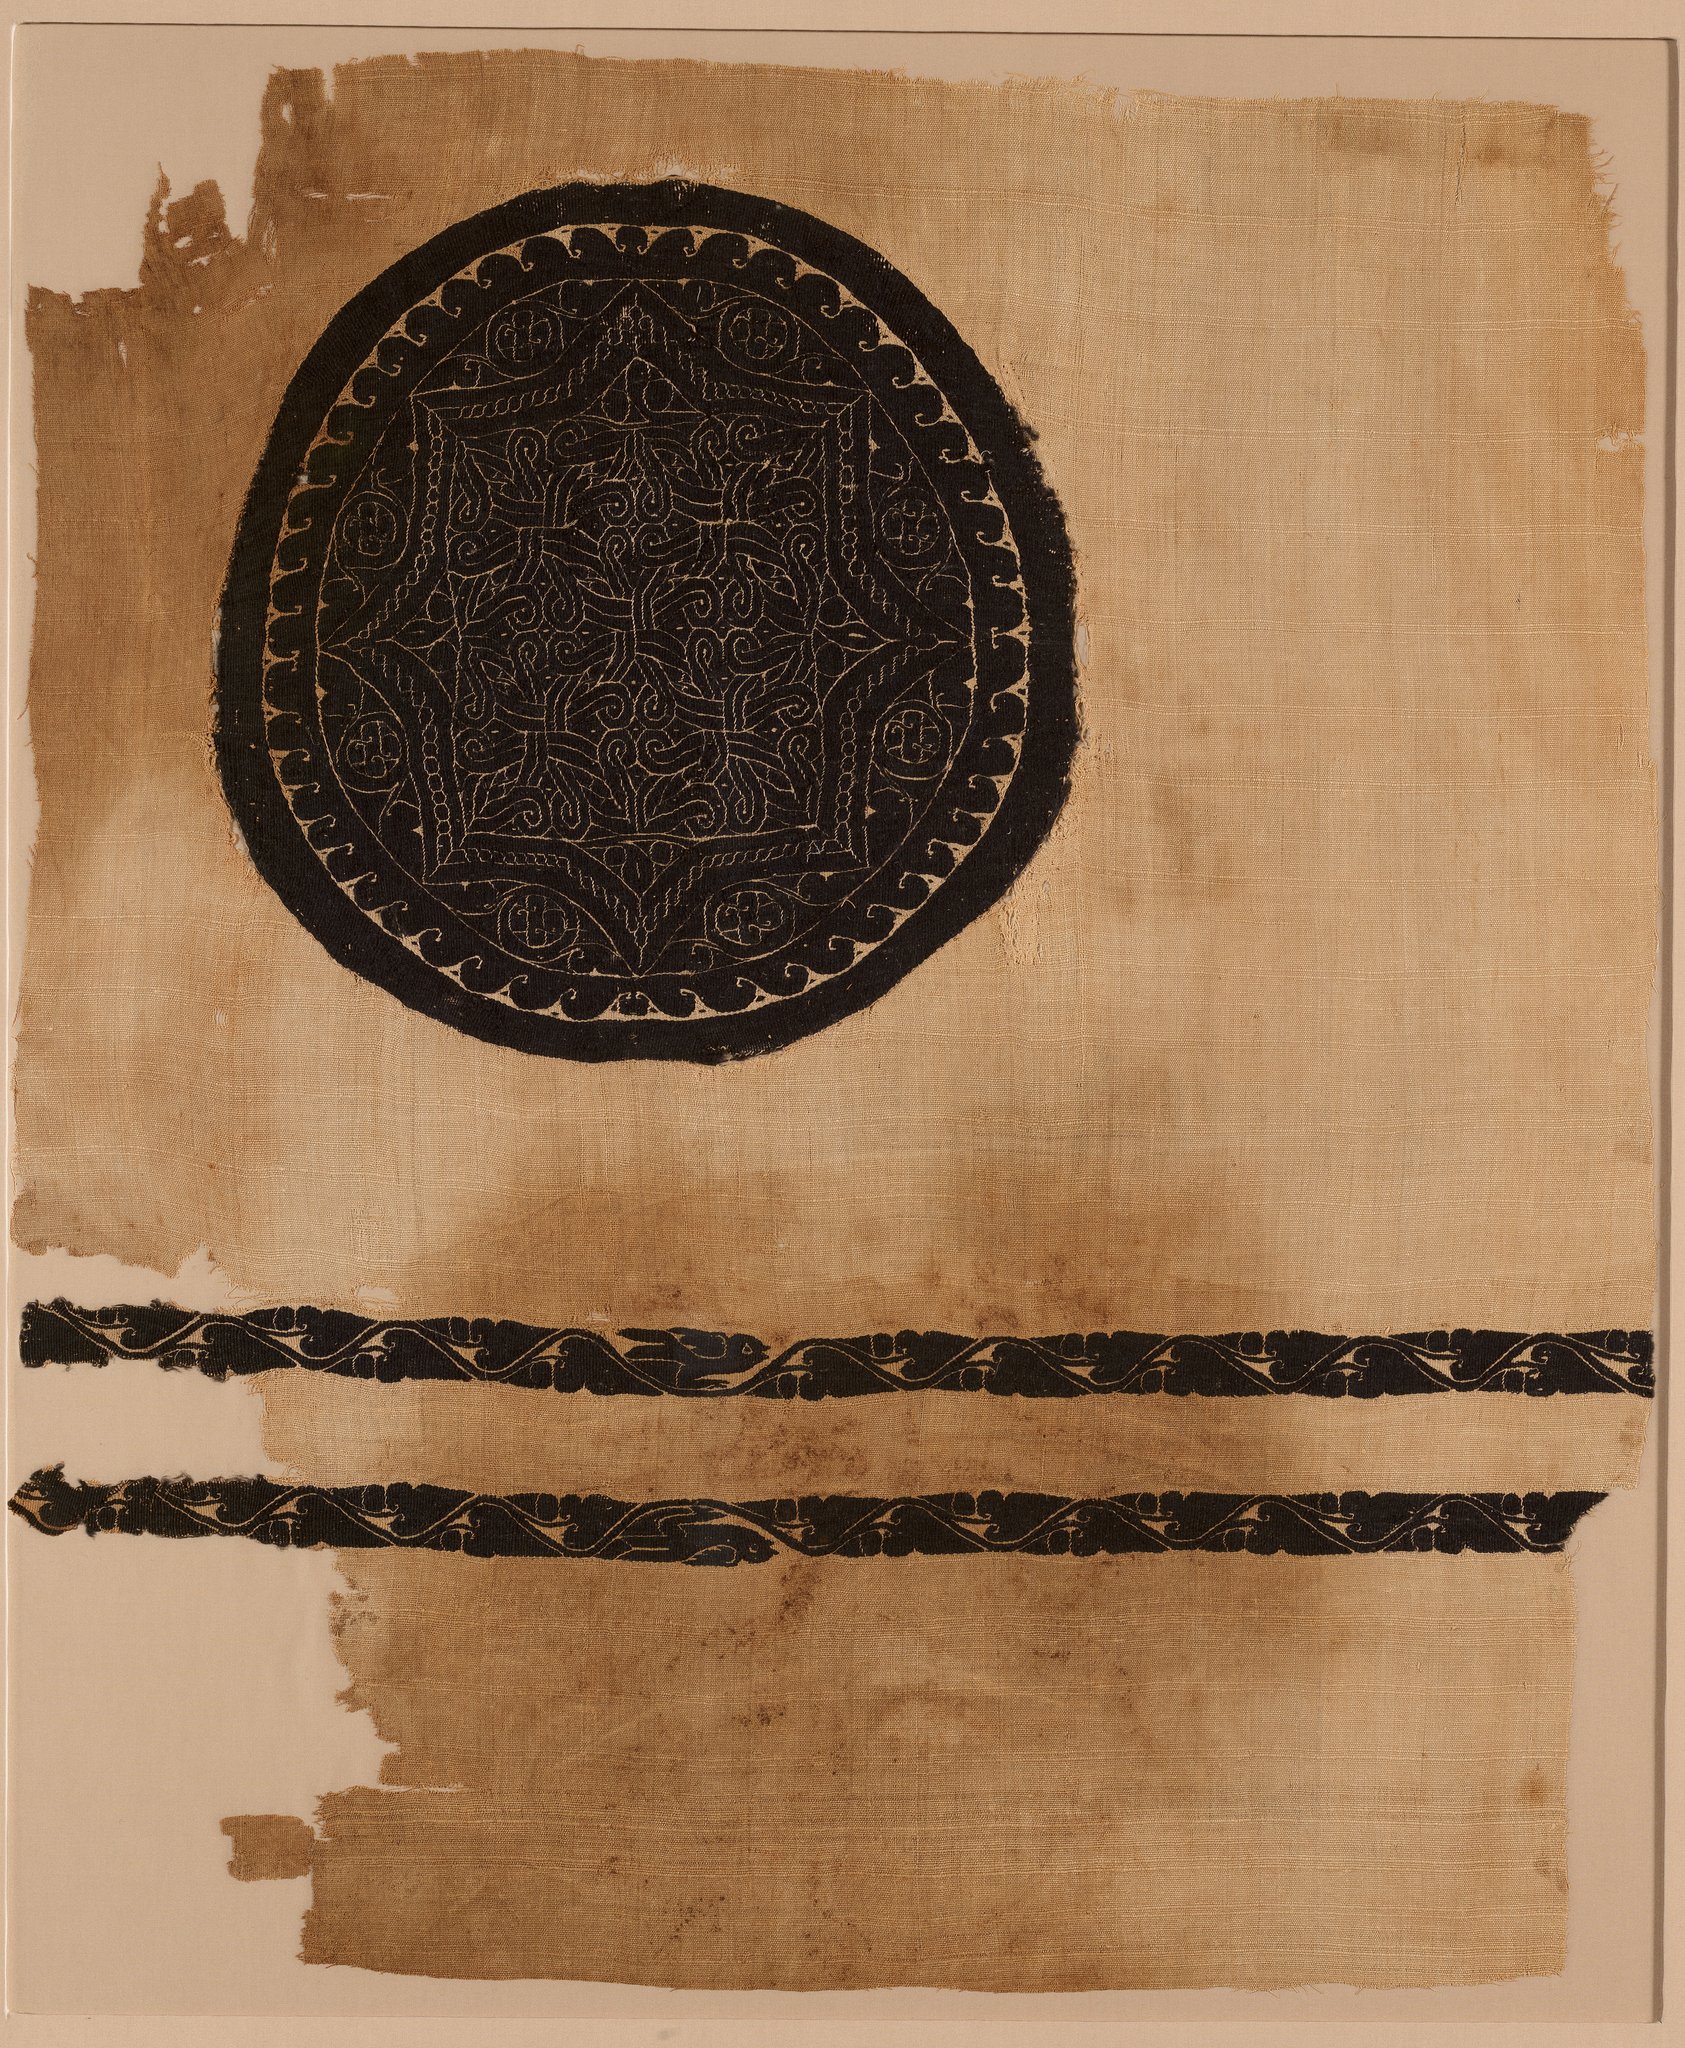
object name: textile fragment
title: Fragment with an Interlace Medallion and Bands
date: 201-600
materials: linen, wool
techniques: weave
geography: egypt